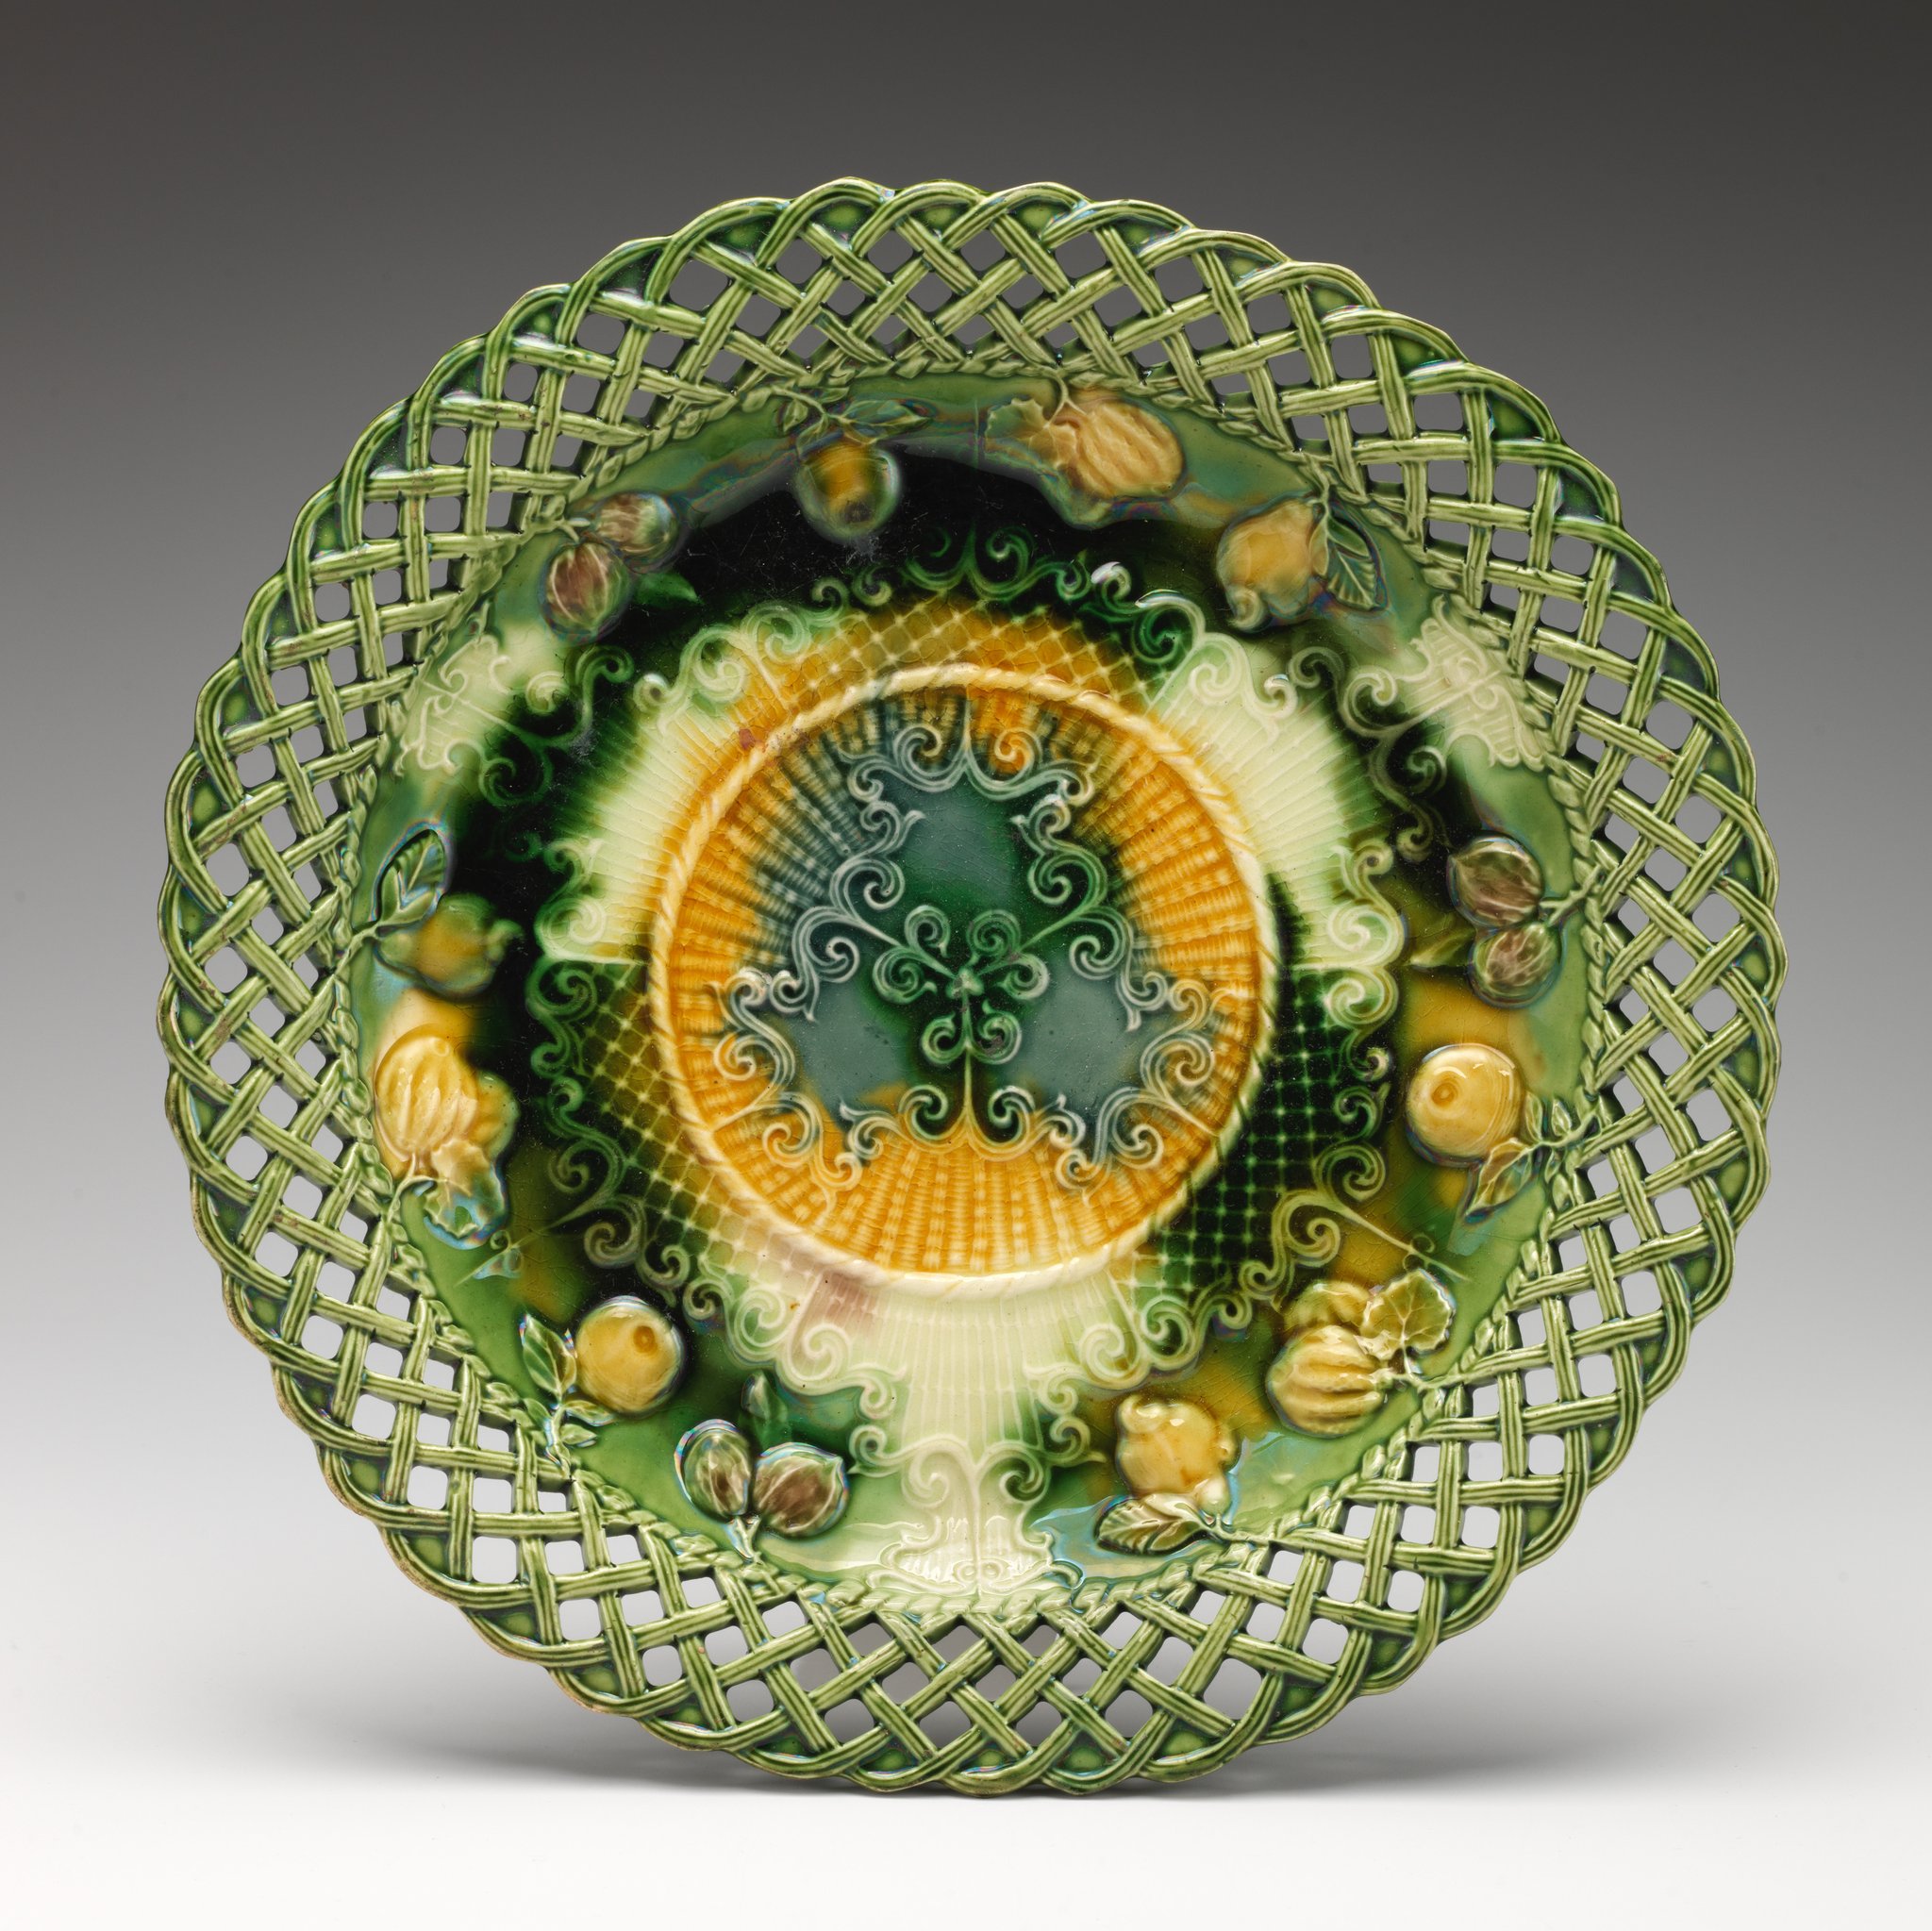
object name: plate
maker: whieldon type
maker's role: maker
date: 1760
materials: earthenware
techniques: glazing